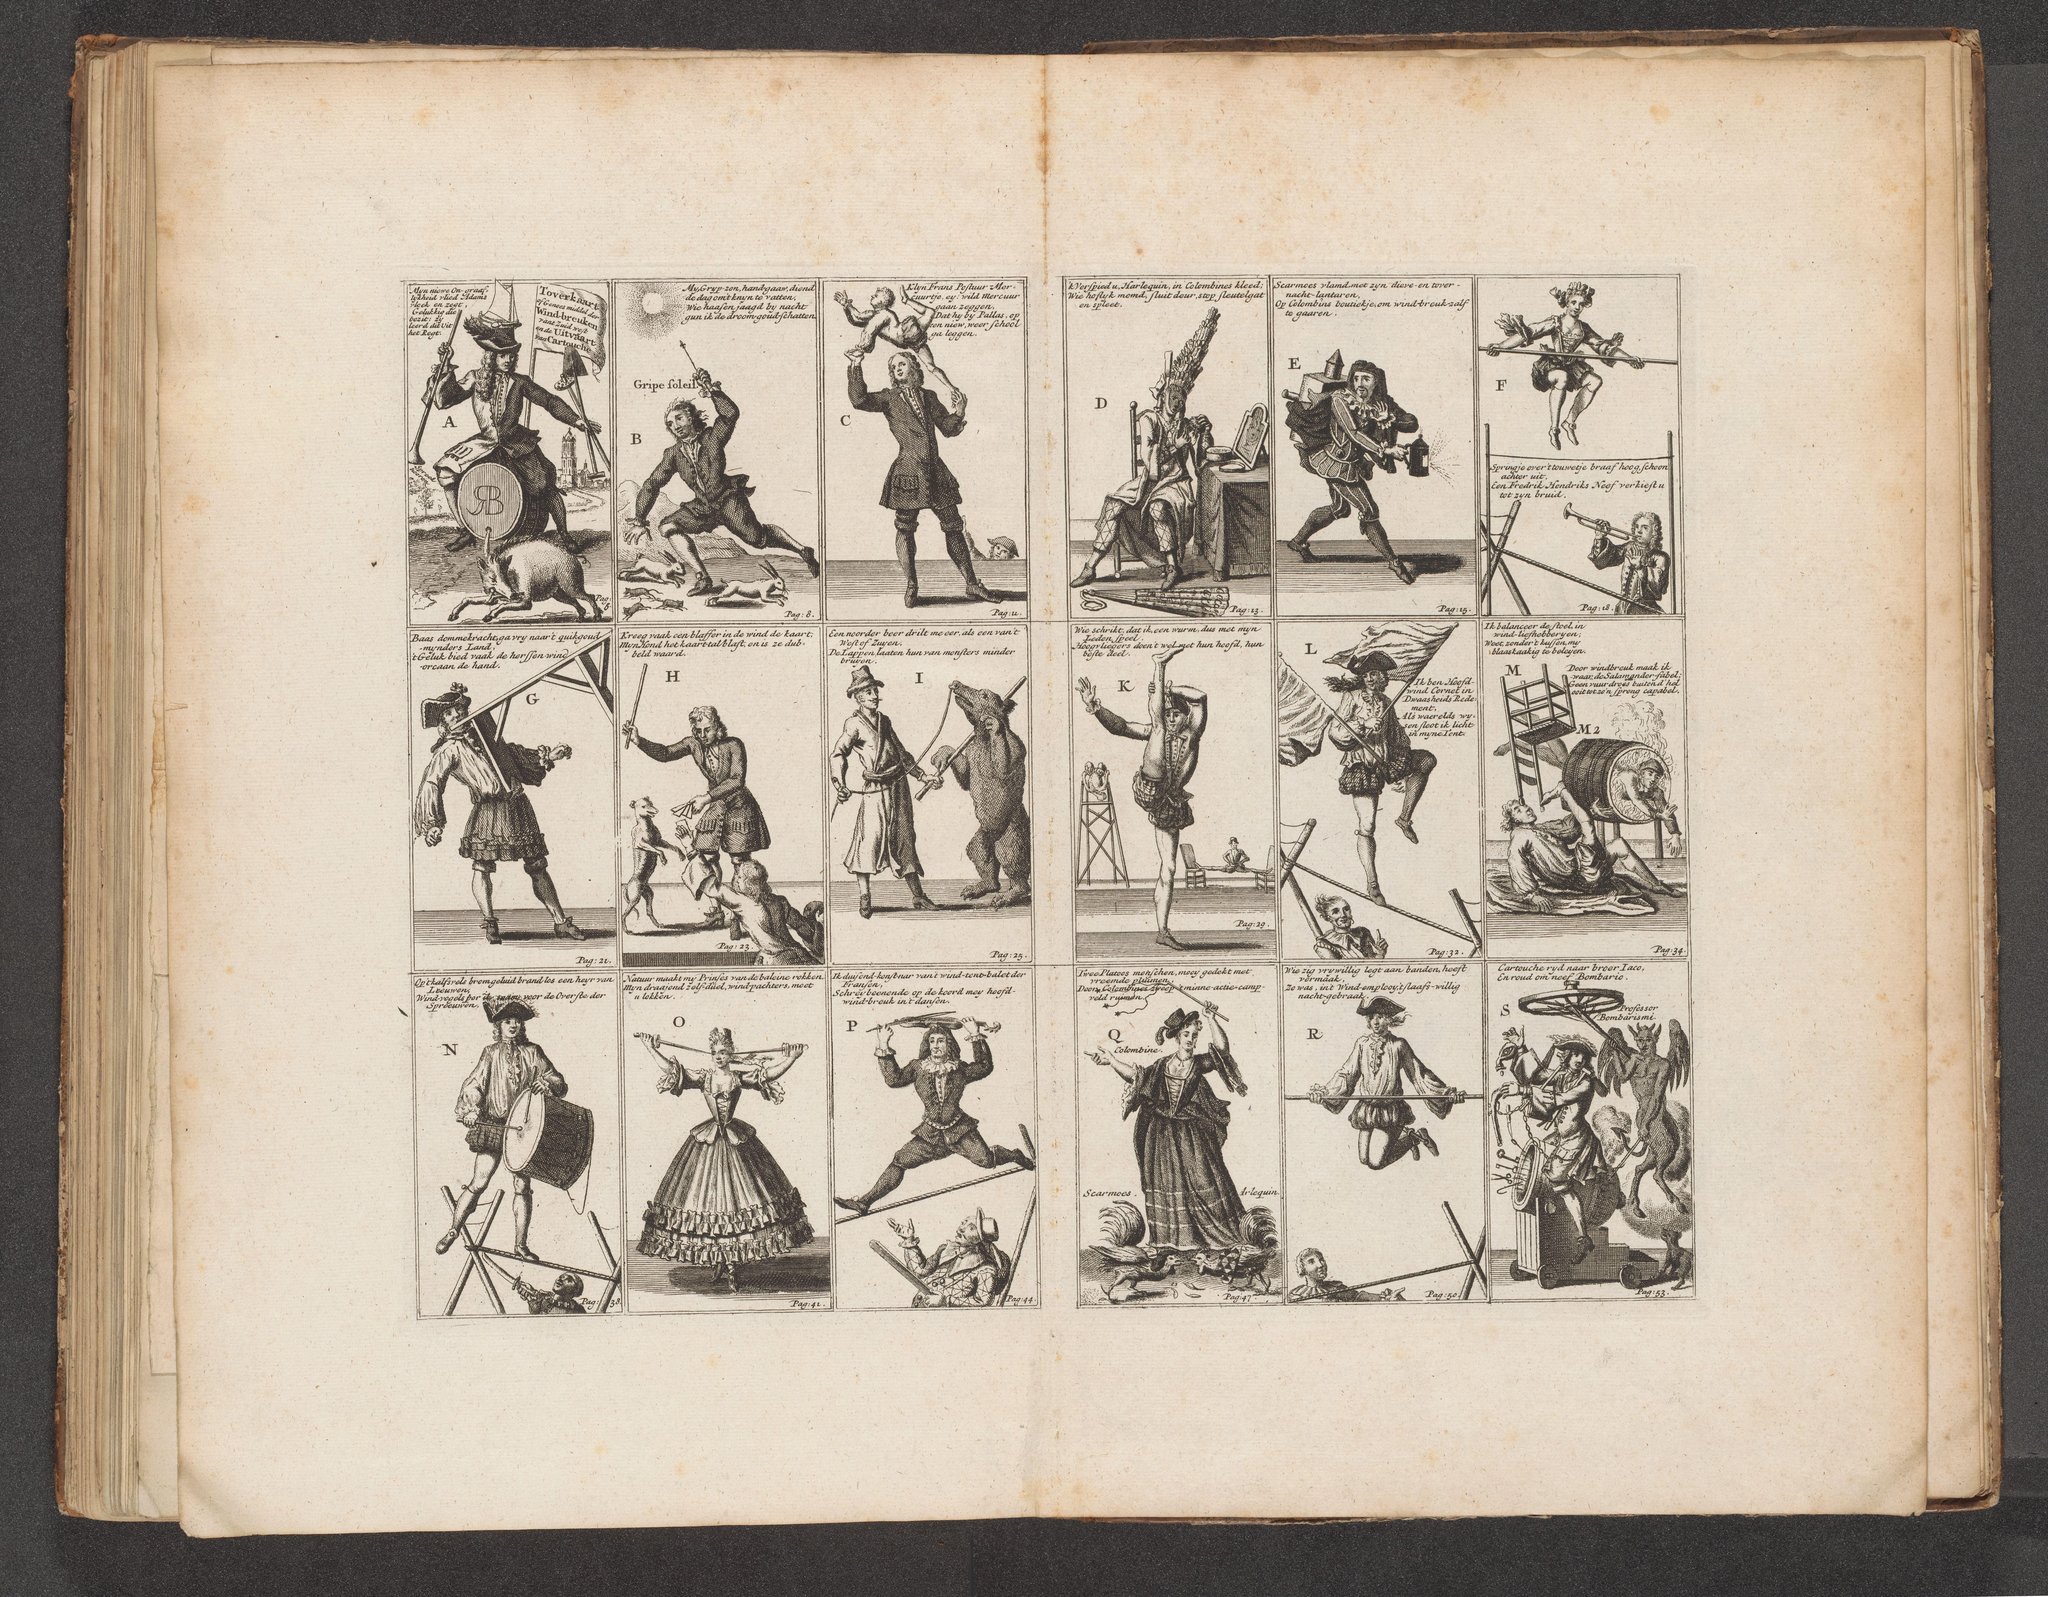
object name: cartoon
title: Toverkaart of geneesmiddel voor de windbreuken, 1720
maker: Anonymous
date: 1720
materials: paper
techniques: etching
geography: northern netherlands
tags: the show; fair and circus performers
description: Toverkaart of geneesmiddel voor de windbreuken. Blad met 18 kleine voorstellingen van circusartiesten, acrobaten en goochelaars, genummerd A-S, elke scène met een paginanummer. Prent in de gebonden vierde uitgave (304 B 12) van Het Groote Tafereel der Dwaasheid met spotprenten op de Windhandel of Actiehandel van 1720.